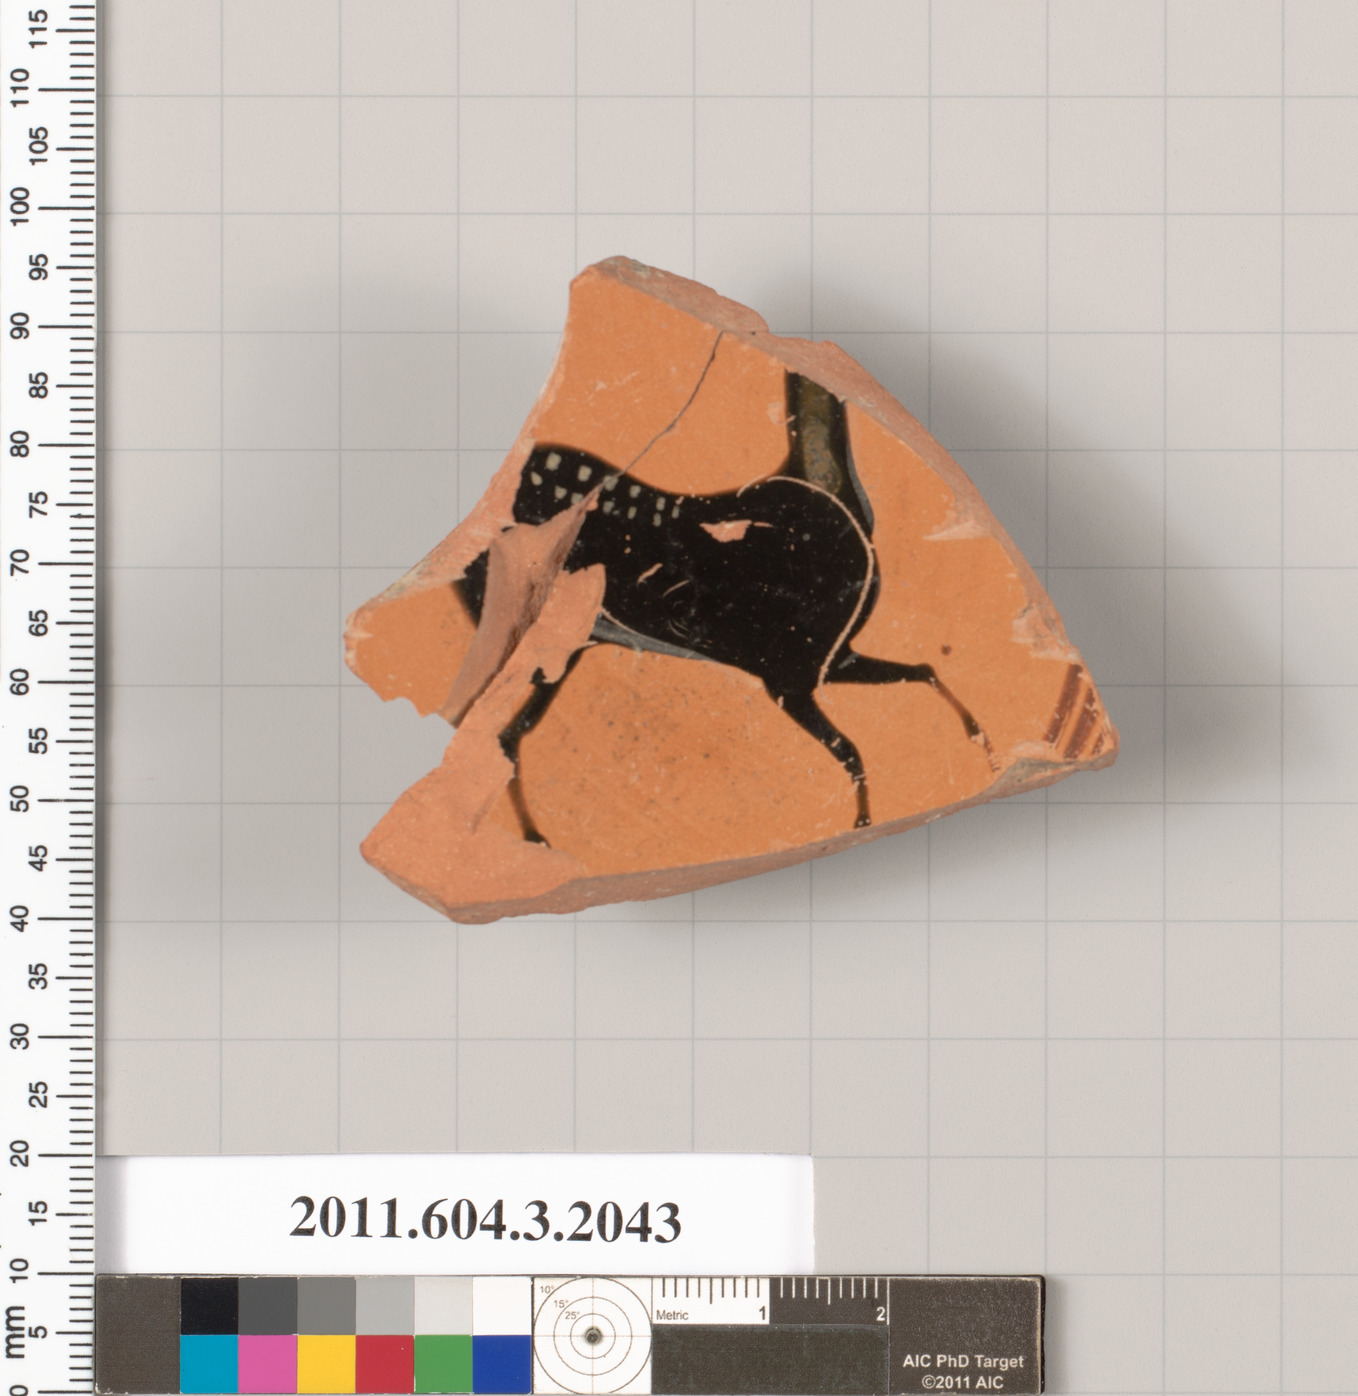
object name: kylix fragment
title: Terracotta fragment of a kylix (drinking cup)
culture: greek, attic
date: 534-501 BCE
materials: terracotta